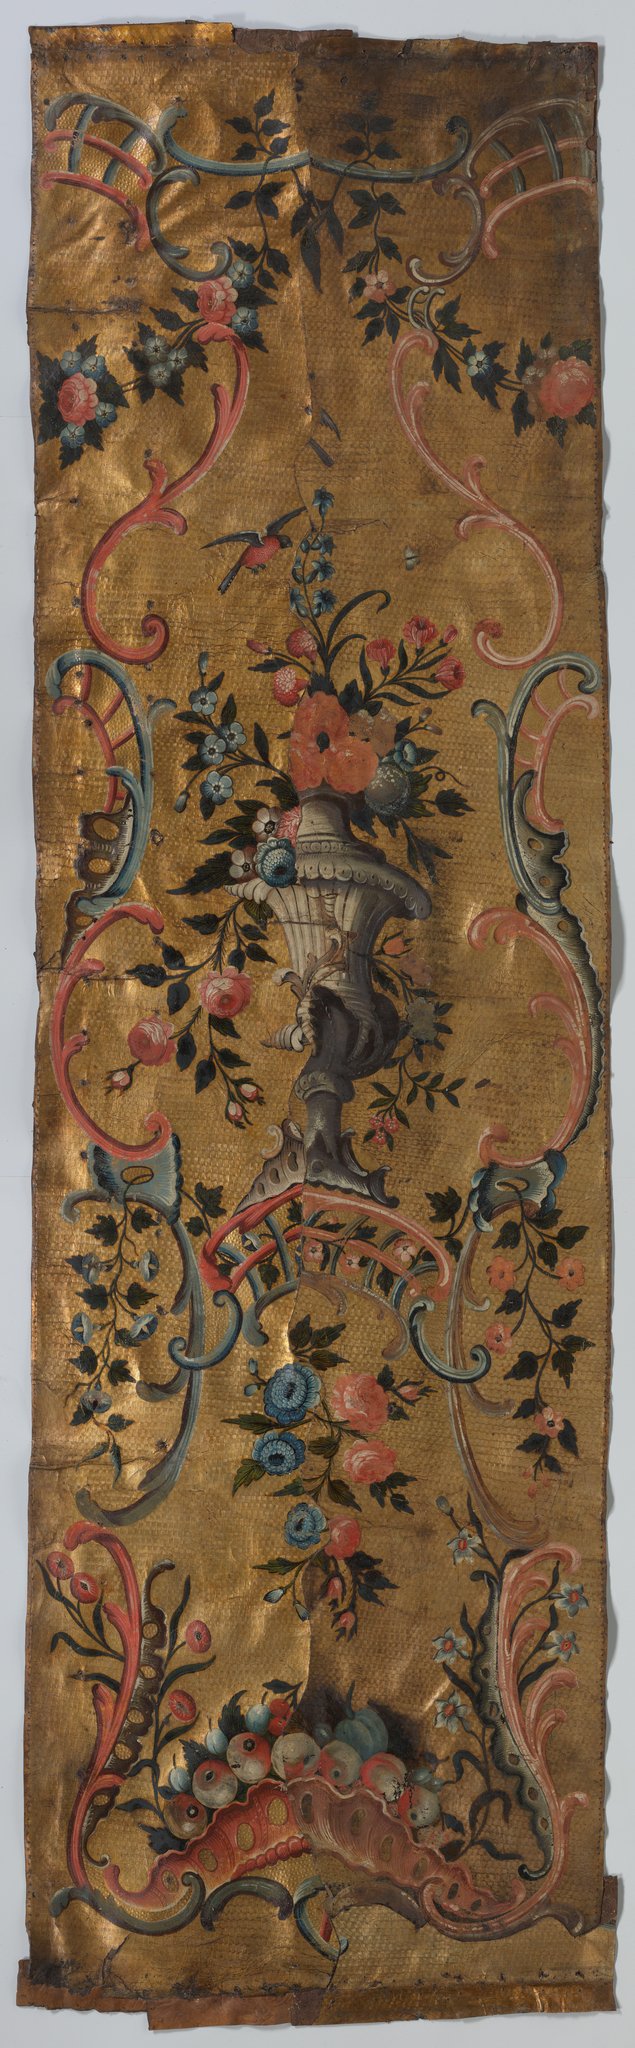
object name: hanging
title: Baan goudleer, verguld geponst fond met beschildering van omramingen van rocailles en S- en C-voluten waarbinnen bloemenvazen, bloem- en vruchtentakken en -slingers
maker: Anonymous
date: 1750-1775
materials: gilt leather, leather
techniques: painted, punching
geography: northern netherlands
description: Het vergulde geponste fond is beschilderd met omramingen van rocailles en S- en C-voluten, waarbinnen bloemenvazen. Onderaan zijn nog vruchten en bloemtakken en bovenaan vruchten en bloemslingers met vogels aangebracht. De beschildering is uitgevoerd in verschillende tinten grijs, rood, groen en blauw.